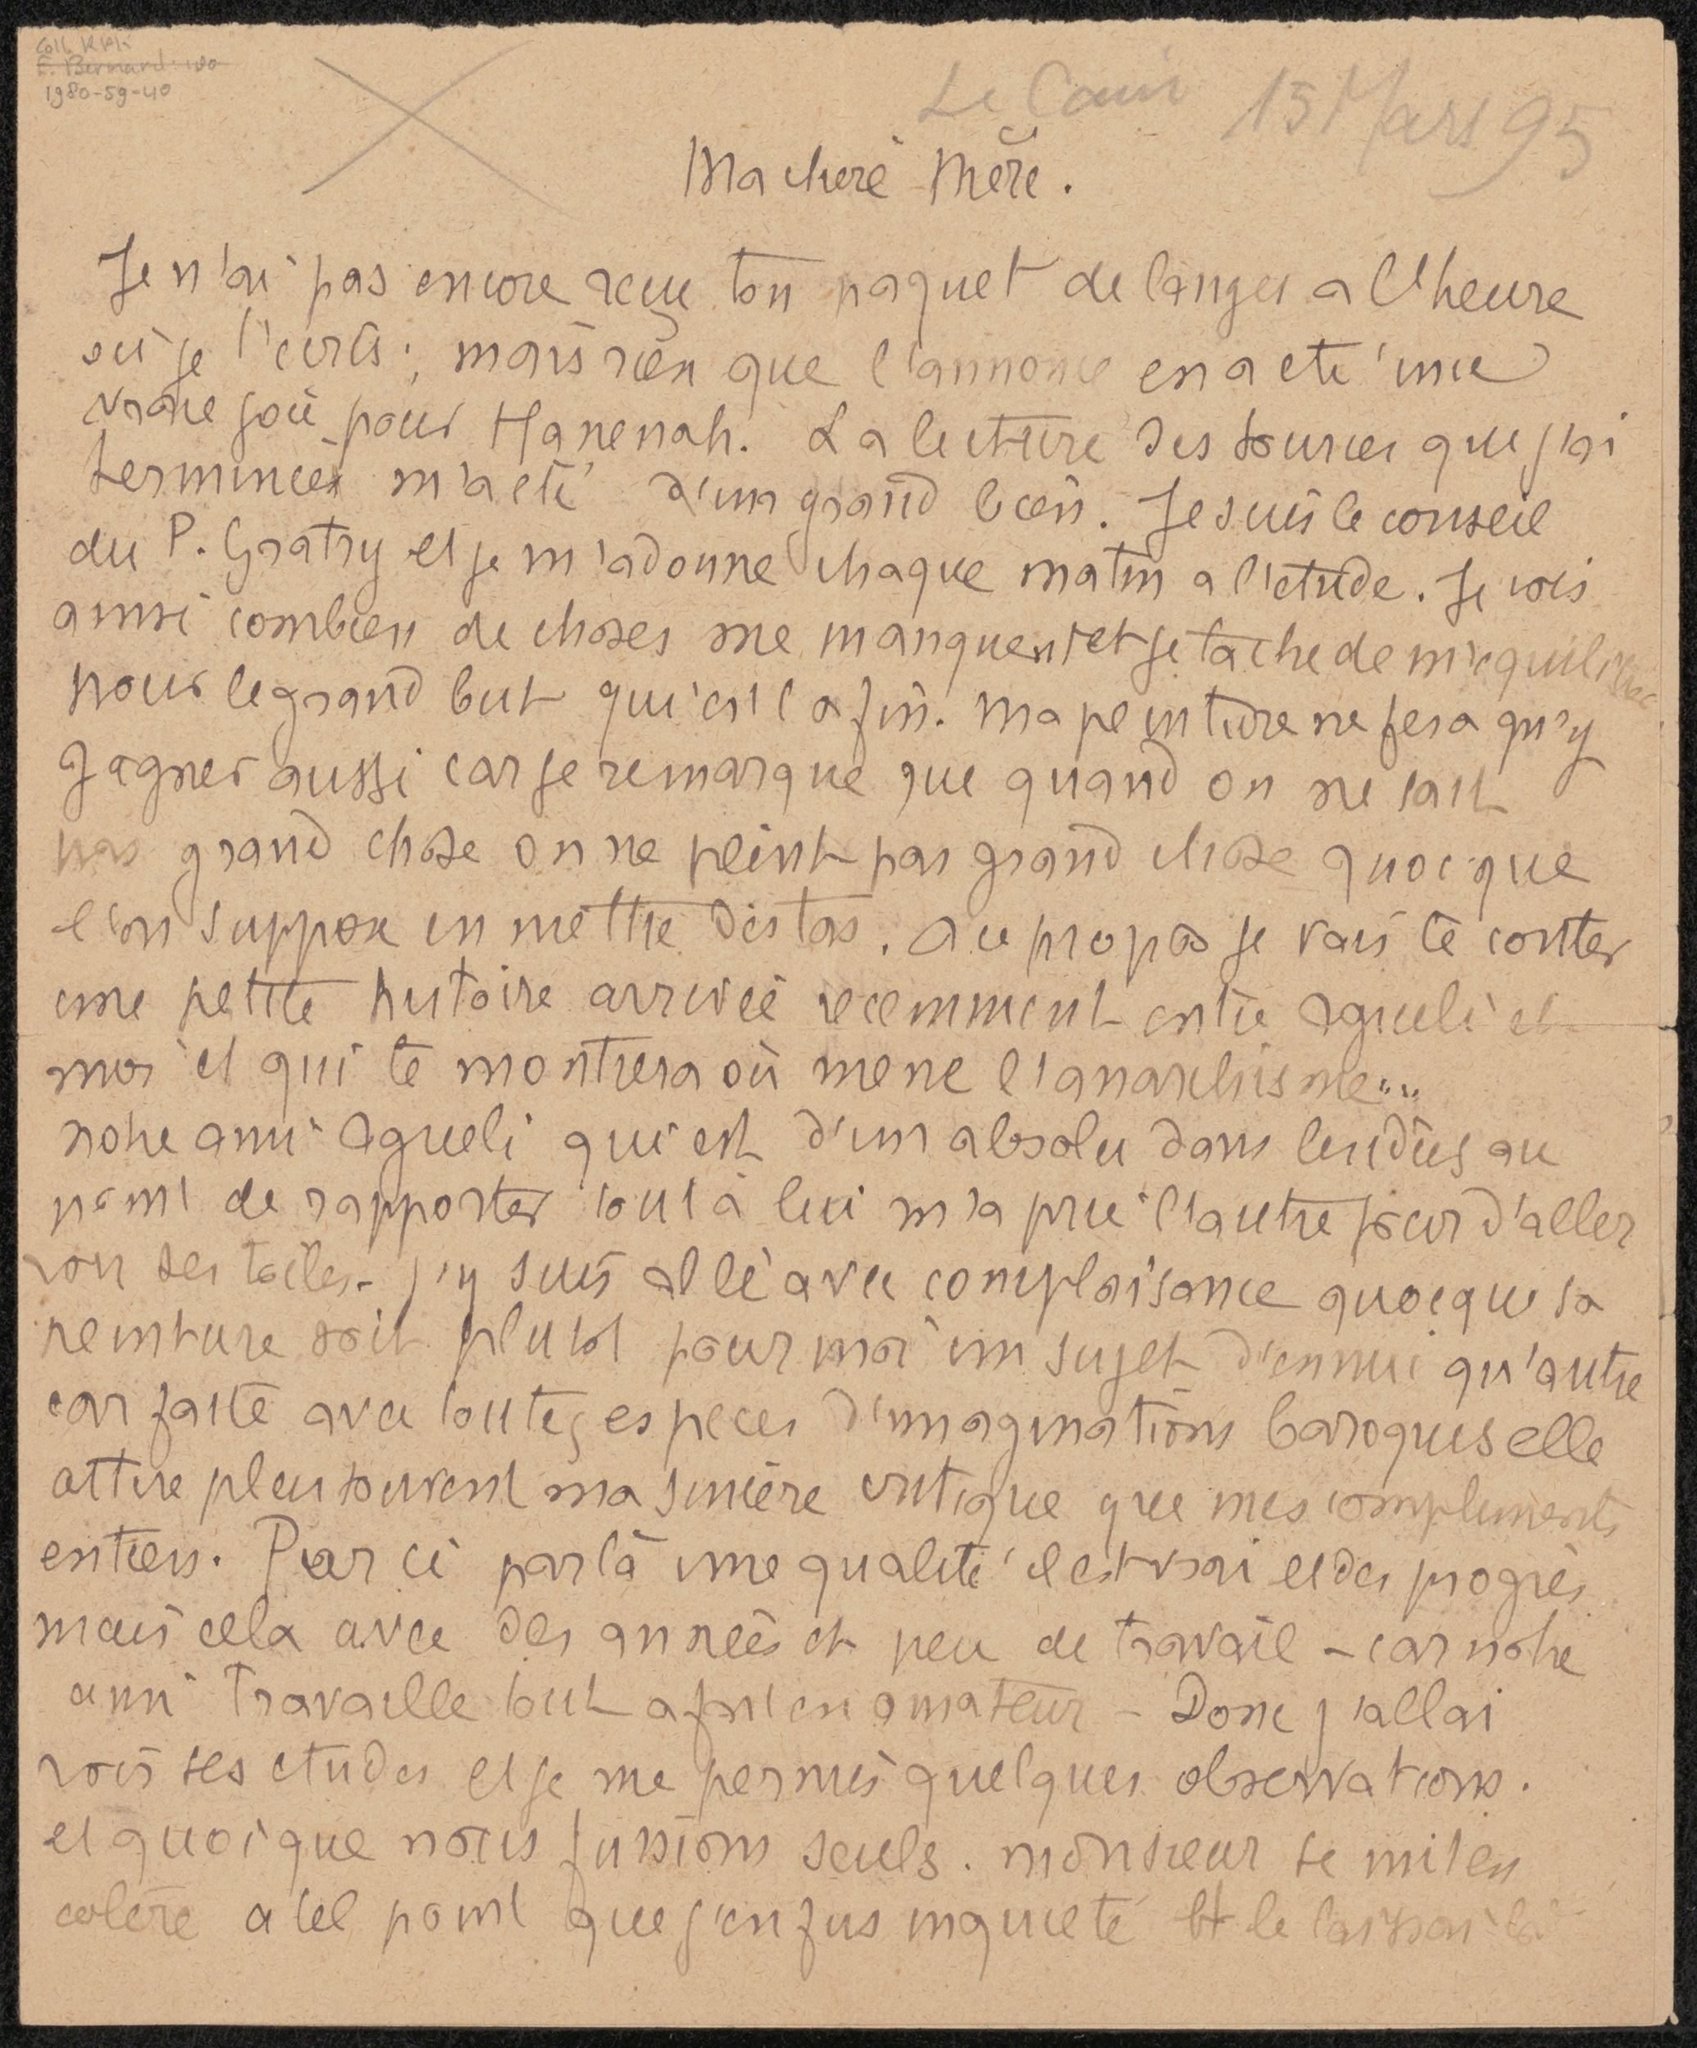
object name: letter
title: Brief aan Héloïse Bernard-Bodin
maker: émile bernard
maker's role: print maker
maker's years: 1868-1941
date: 1895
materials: ink, paper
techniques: pen, writing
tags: héloïse bernard-bodin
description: Brief gedateerd 15 Mars 95 in latere hand.